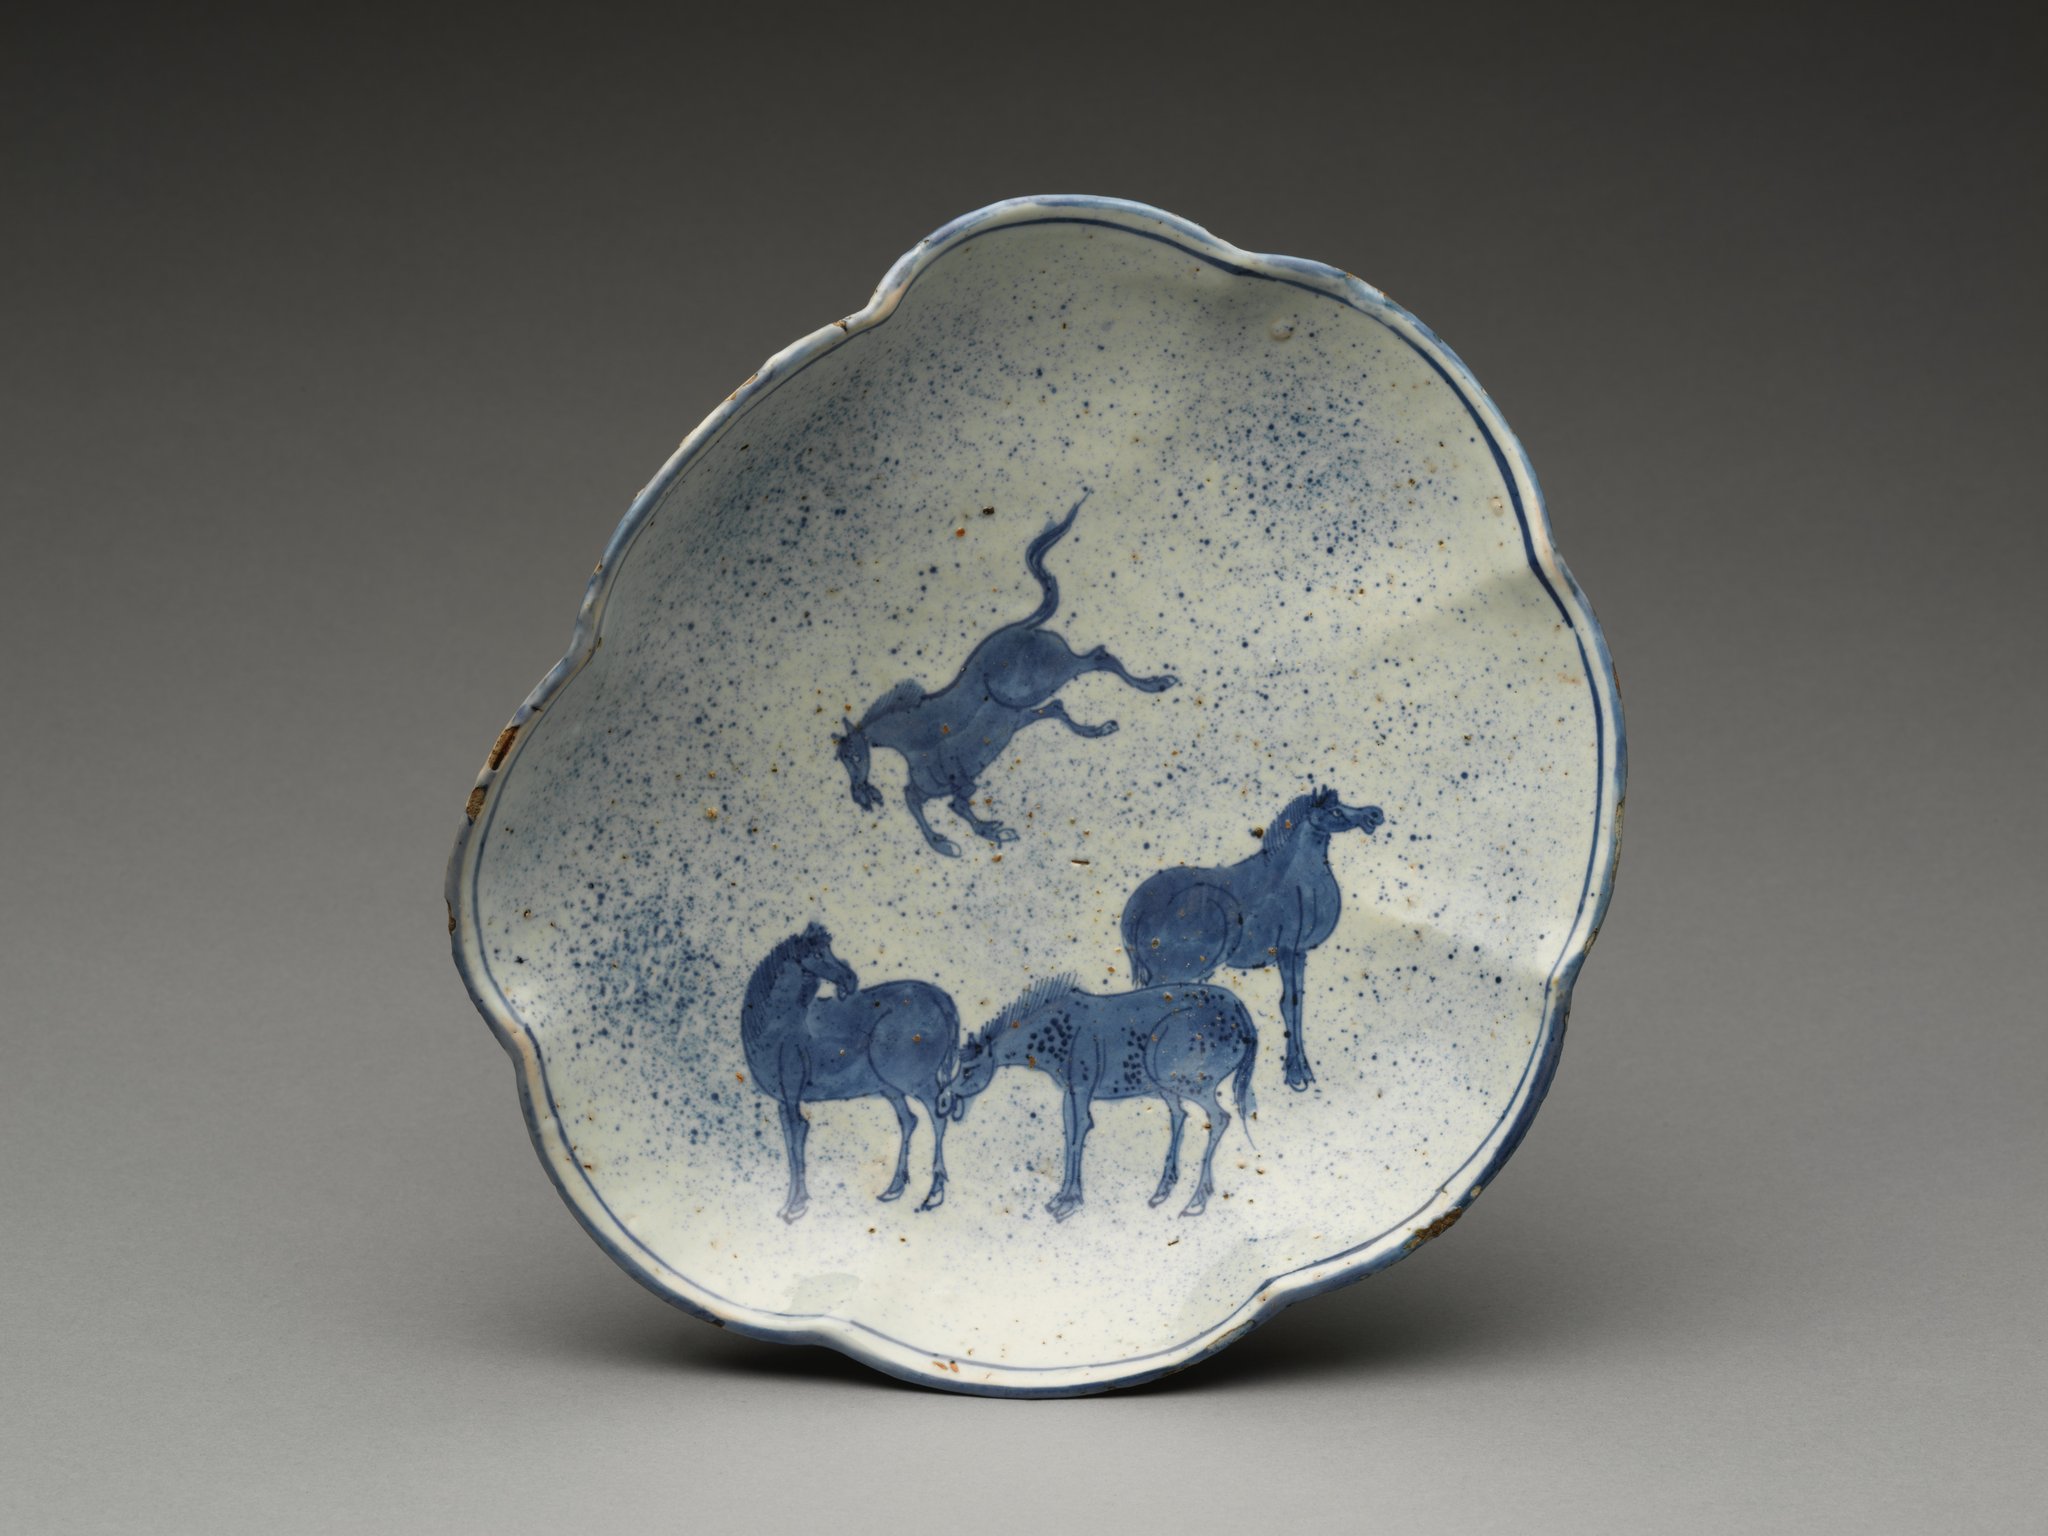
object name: bowl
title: Bowl with four horses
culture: chinese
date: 1601-1633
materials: cobalt, porcelain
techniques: painting, underglaze